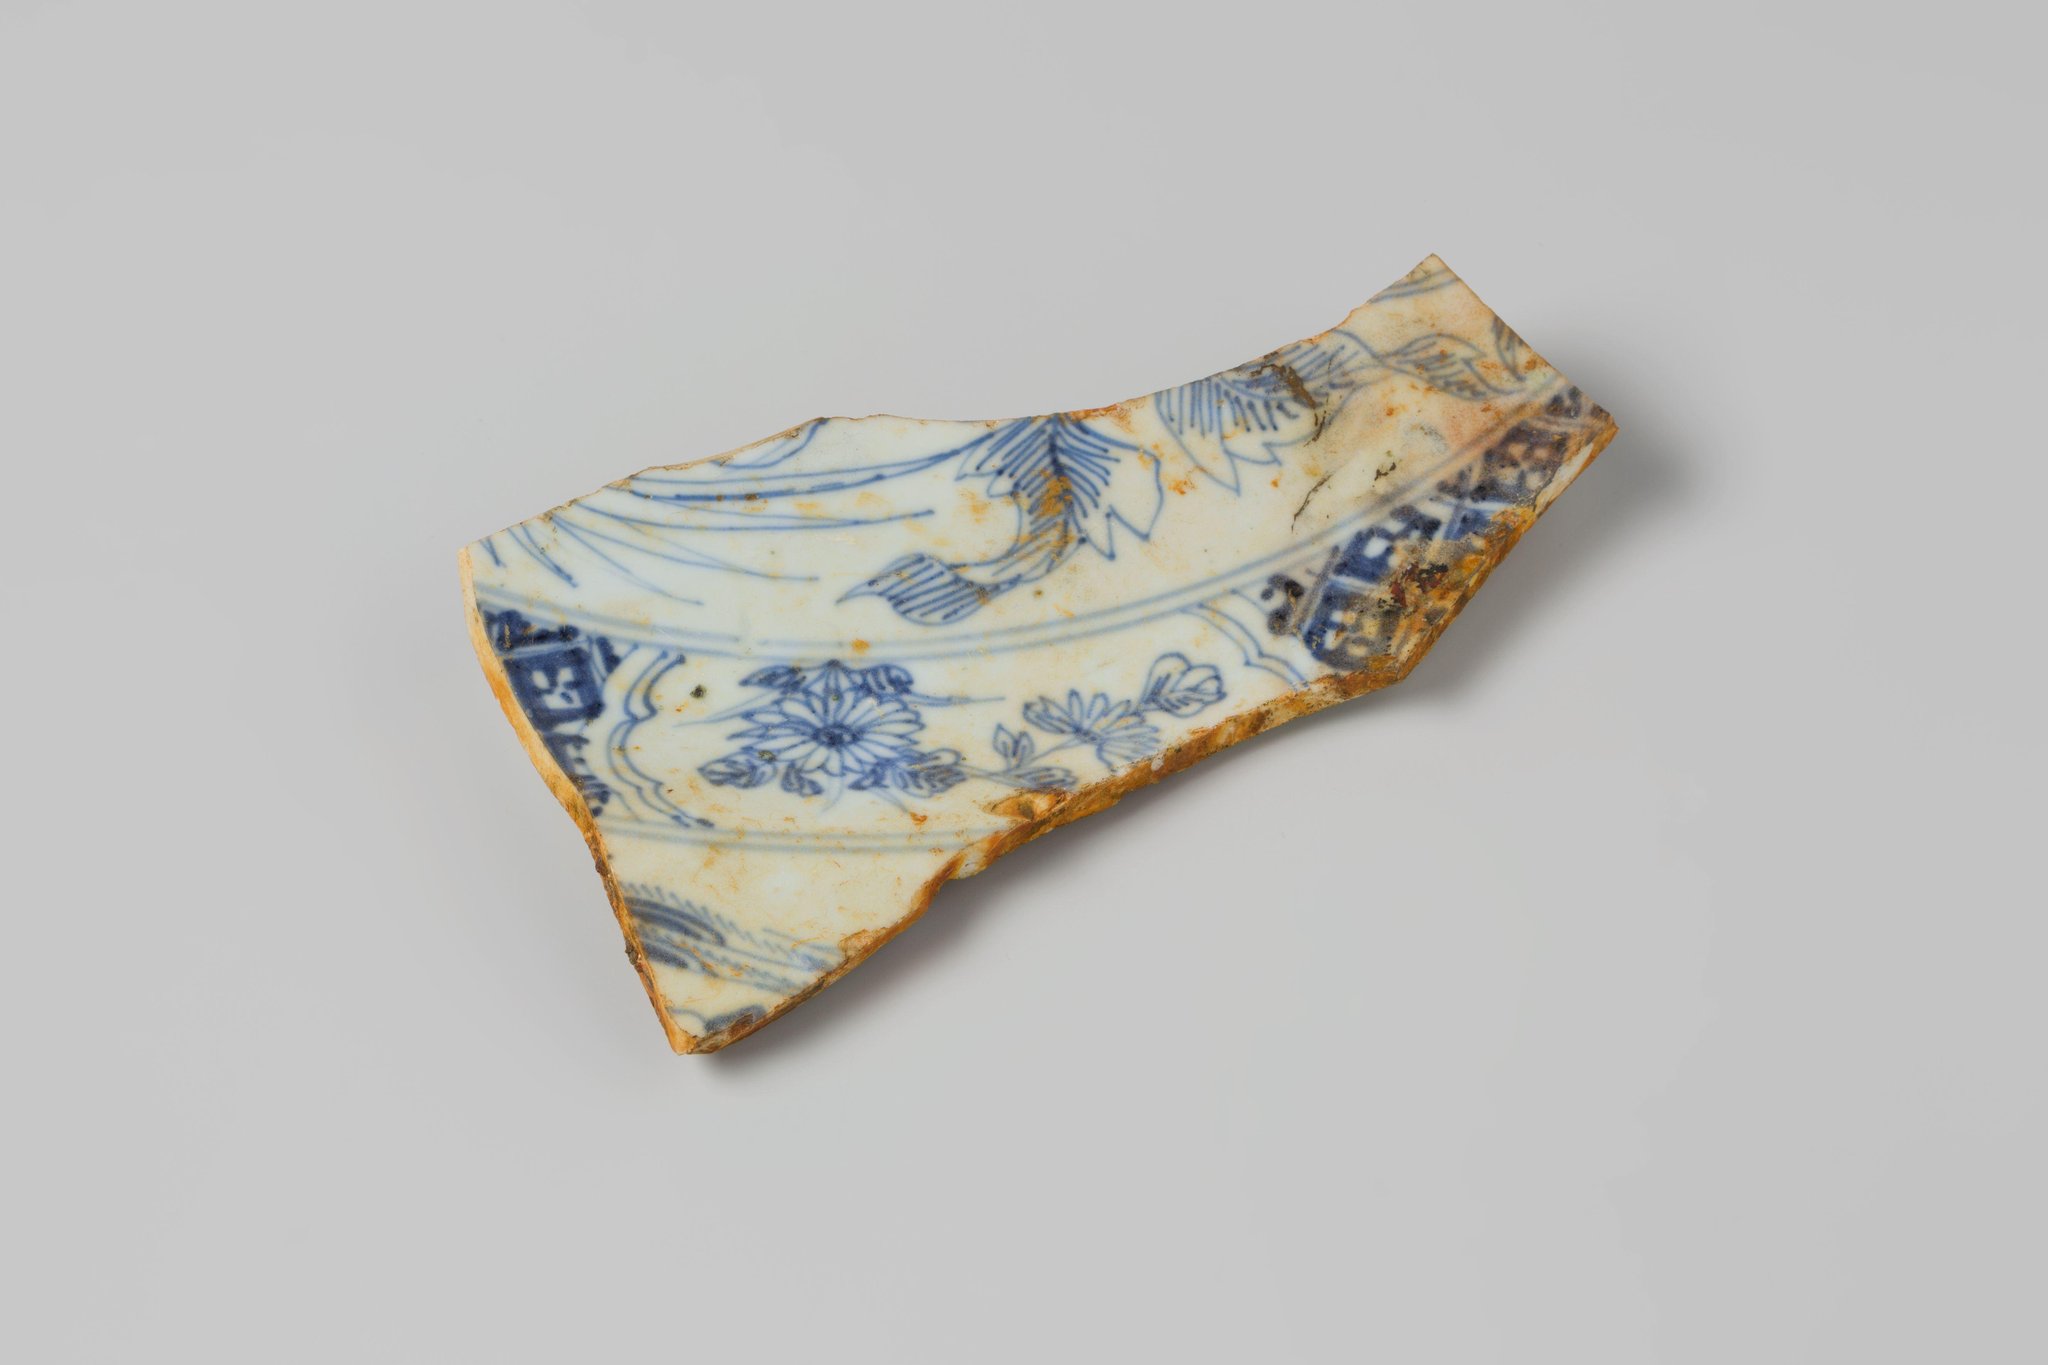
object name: sherd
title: Scherf van een bord uit het wrak van de Oost-Indiëvaarder Hollandia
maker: Anonymous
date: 1700-1743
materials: porcelain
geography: netherlands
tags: verenigde oostindische compagnie, hollandia (schip), annet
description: Porcelain, plate, type 2; fragm of base, sim. NG 1980-27H507.